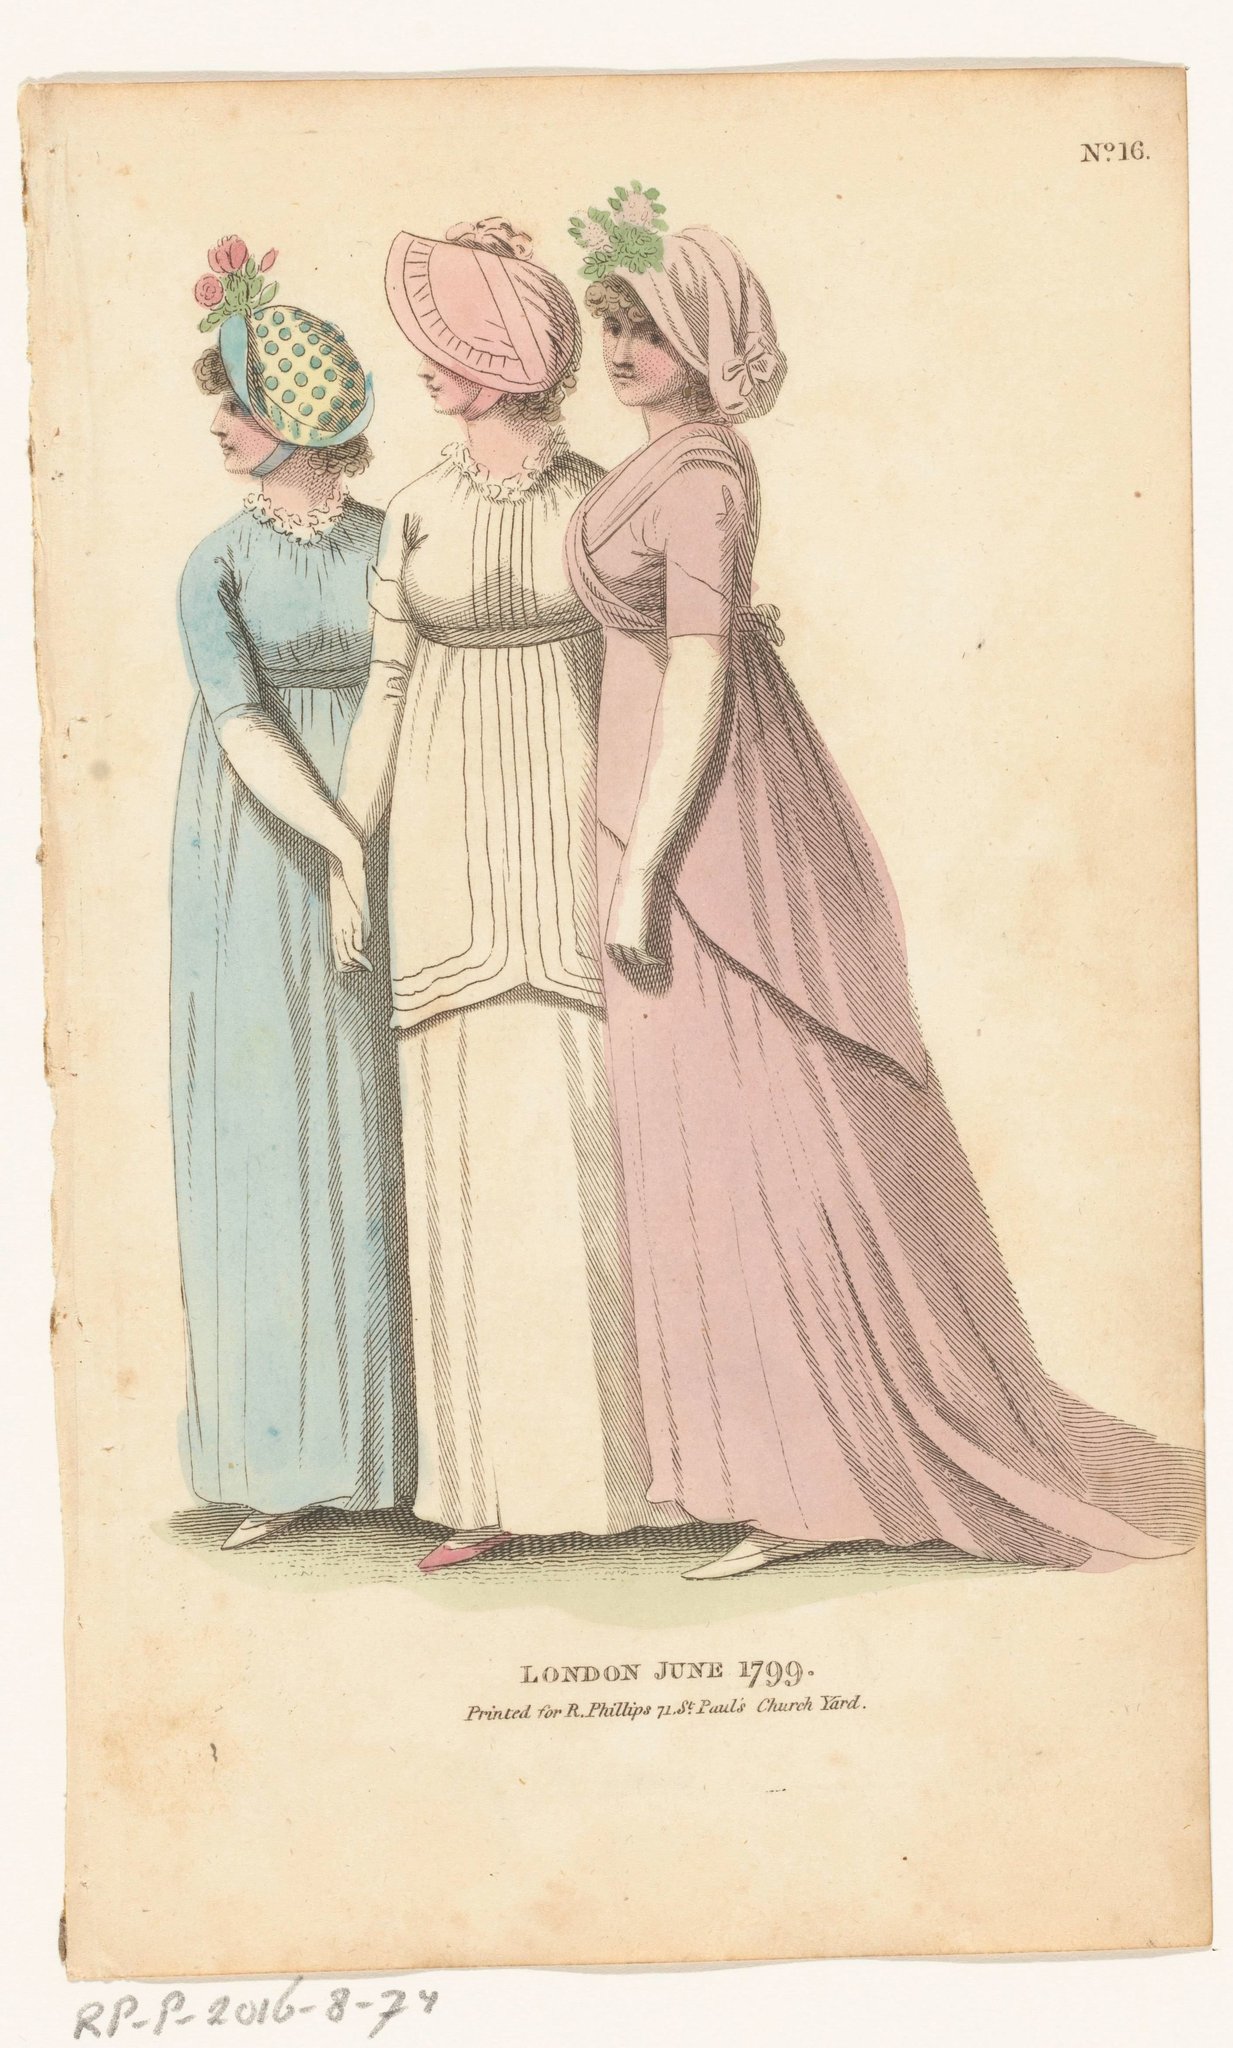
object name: fashion print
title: Magazine of Female Fashions of London and Paris. No. 16: London June 1799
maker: richard phillips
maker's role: bookseller, publisher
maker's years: 1767-1840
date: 1799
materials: paper, ink, watercolor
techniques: etching, hand coloring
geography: london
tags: fashion plates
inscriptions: collector's mark: Lugt 2228